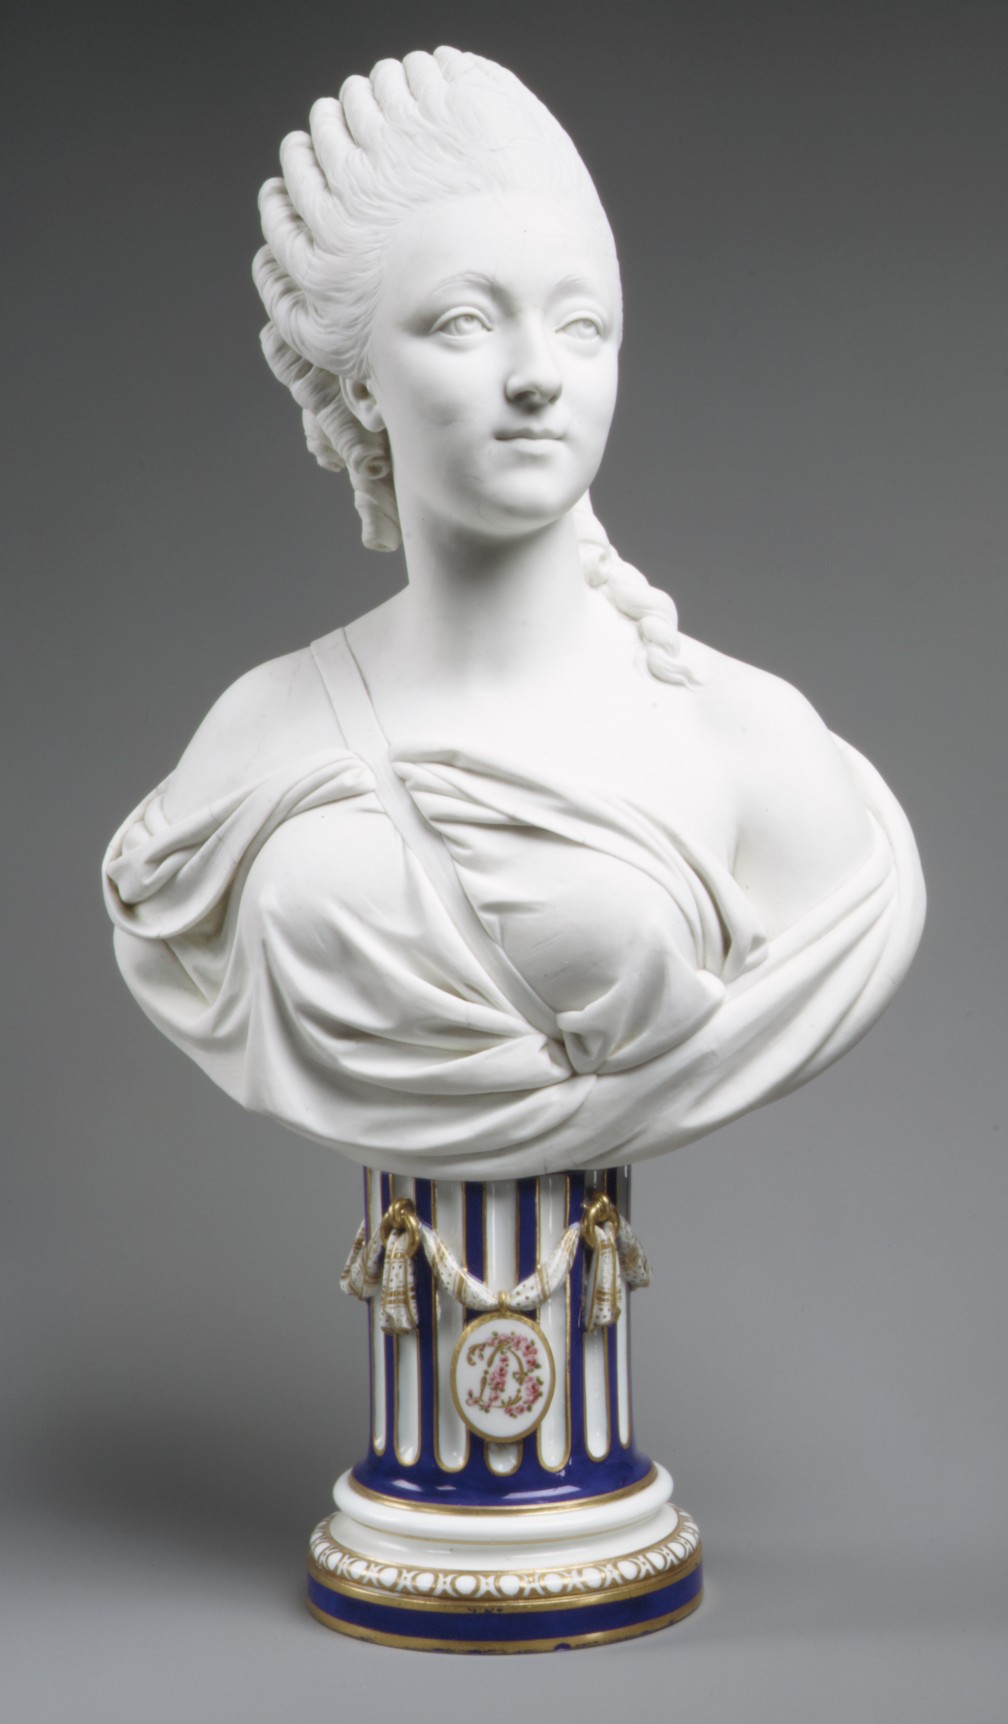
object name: bust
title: Madame du Barry (1746–1793)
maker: sèvres manufactory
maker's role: manufactory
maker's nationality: french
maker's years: 1740-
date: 1772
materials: biscuit, gilt, paste, porcelain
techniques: enamel, glazing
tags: portraits,women